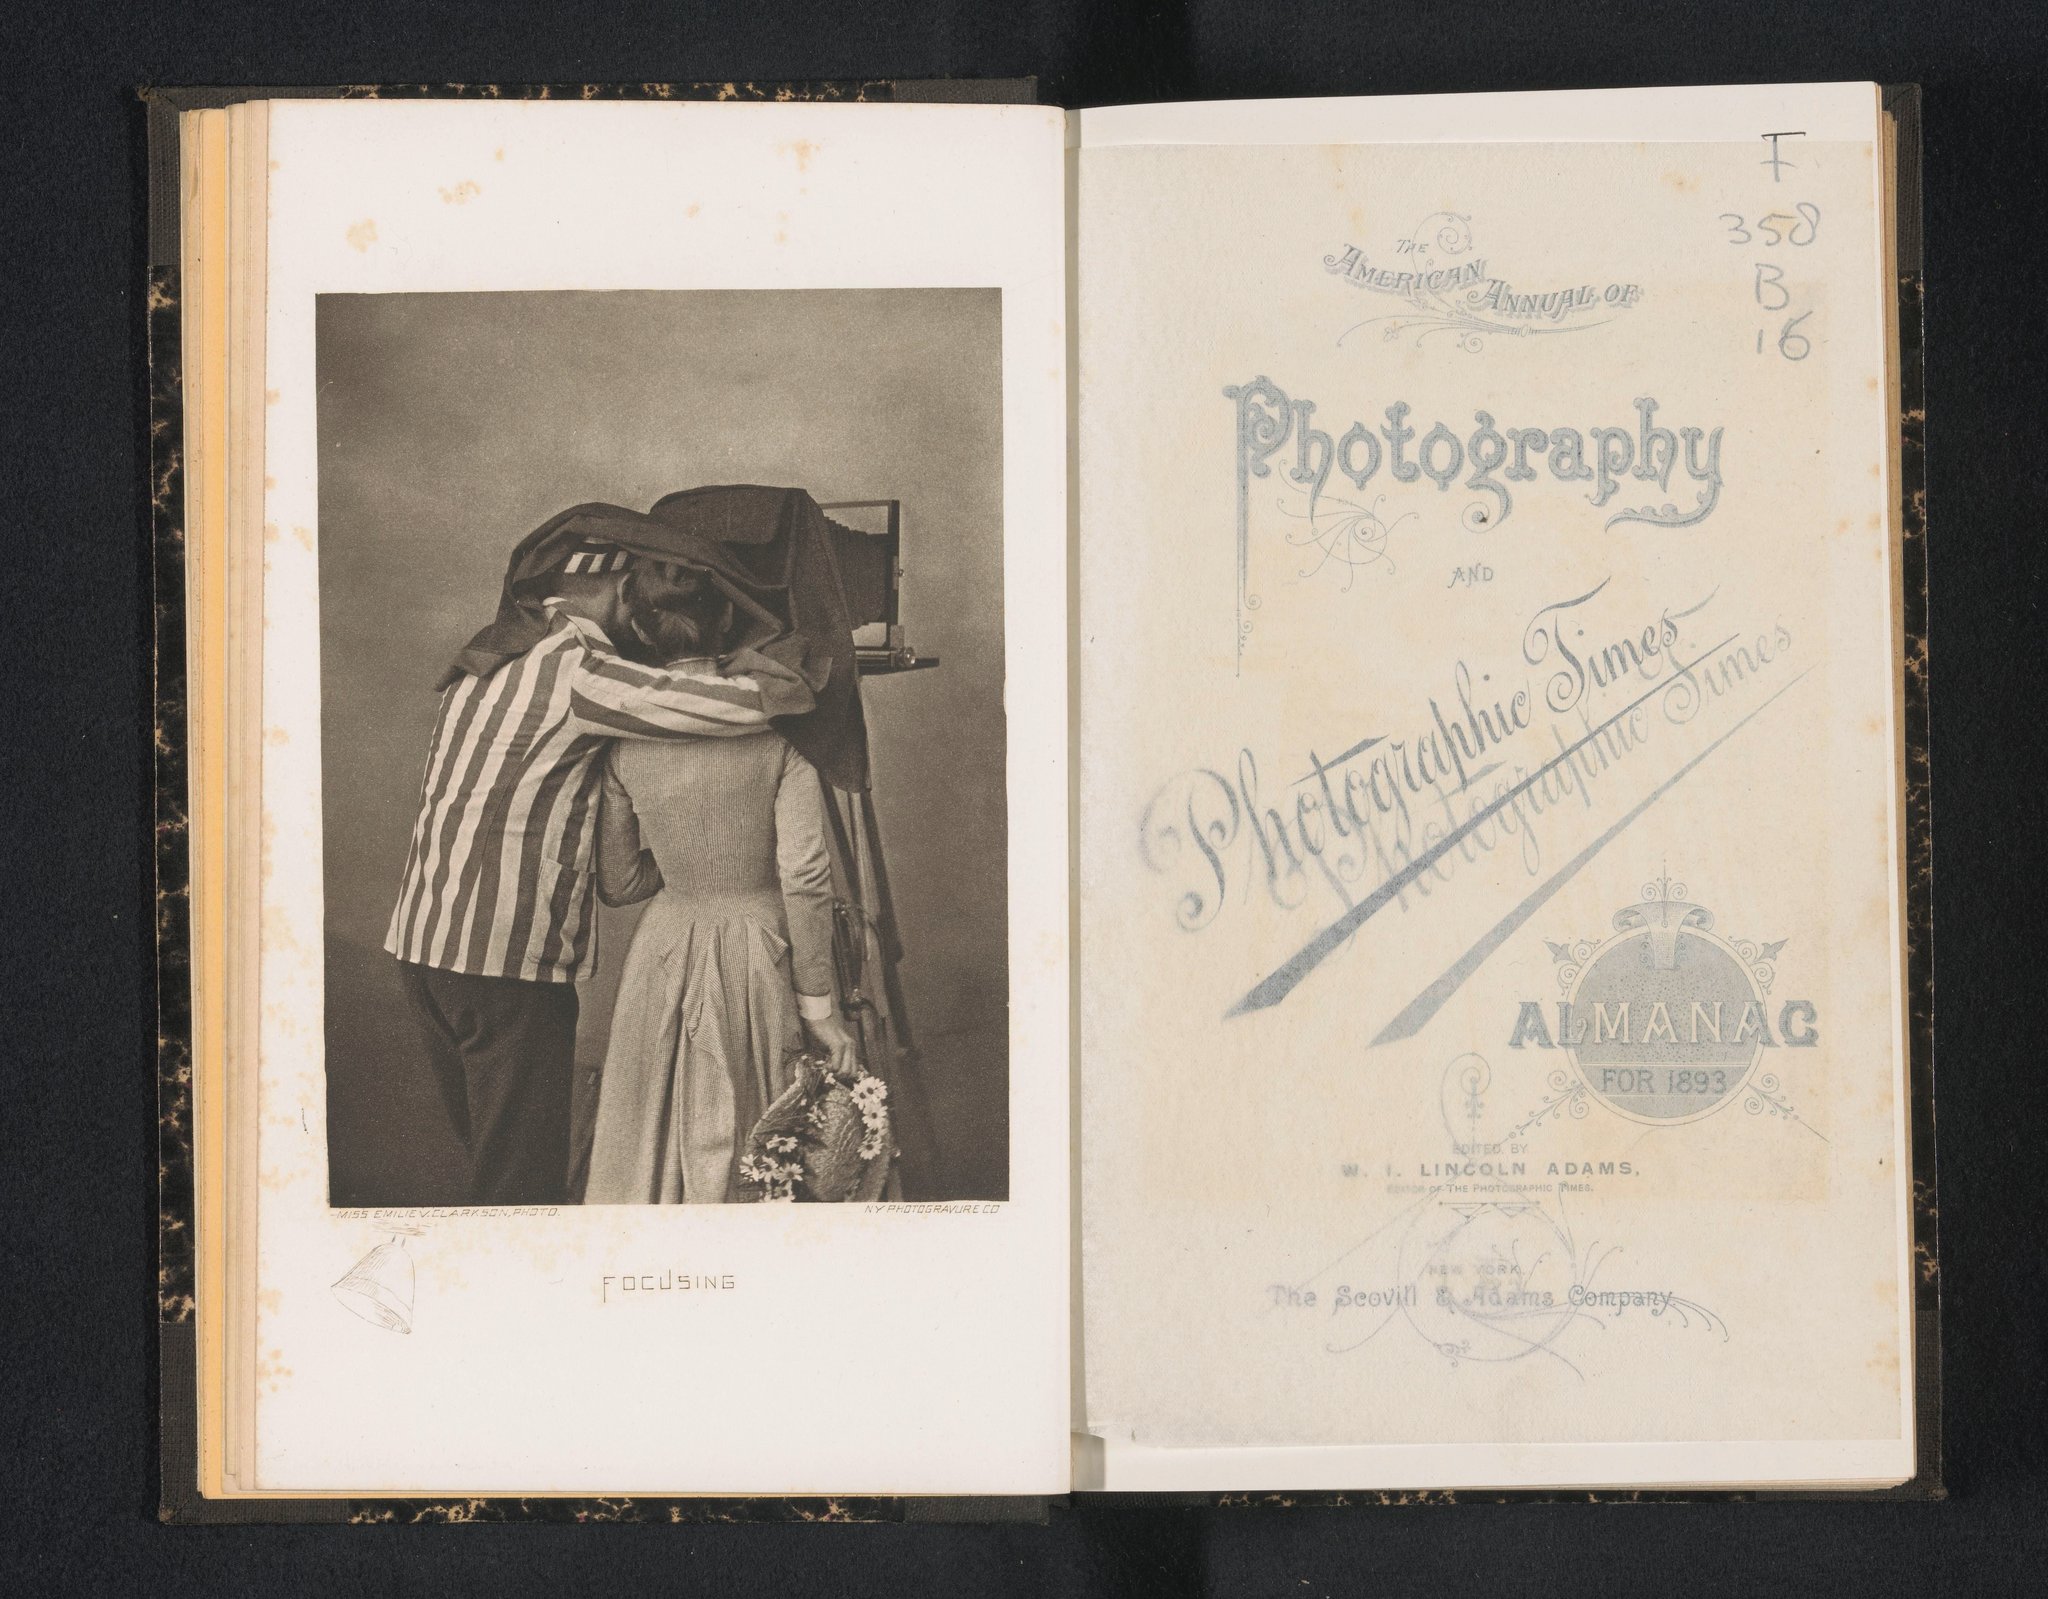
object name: photomechanical print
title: Focusing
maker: emilie v. clarkson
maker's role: fotograaf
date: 1887-1897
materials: paper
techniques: photograph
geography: new york city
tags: camera ~ photography, historical persons